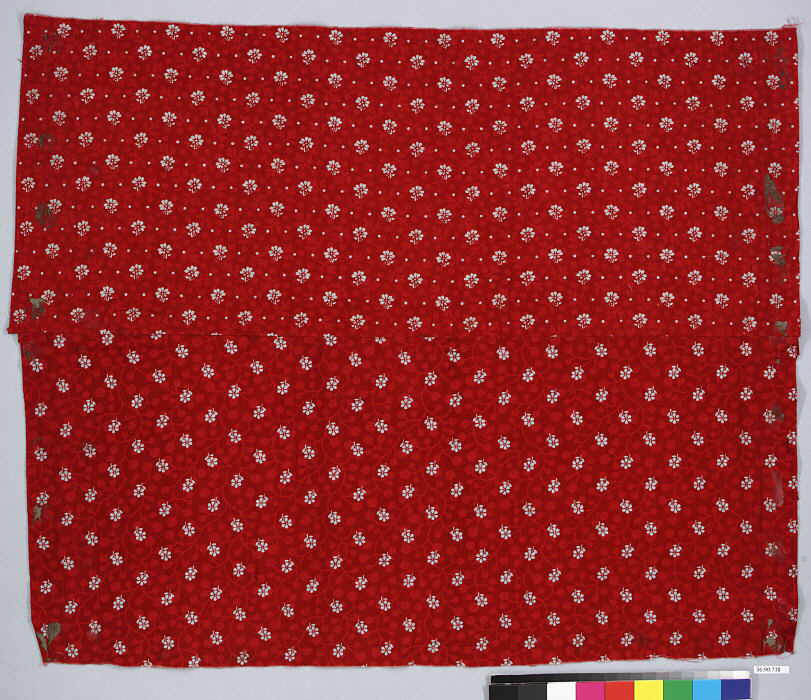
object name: piece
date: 1867-1900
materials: cotton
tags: flowers